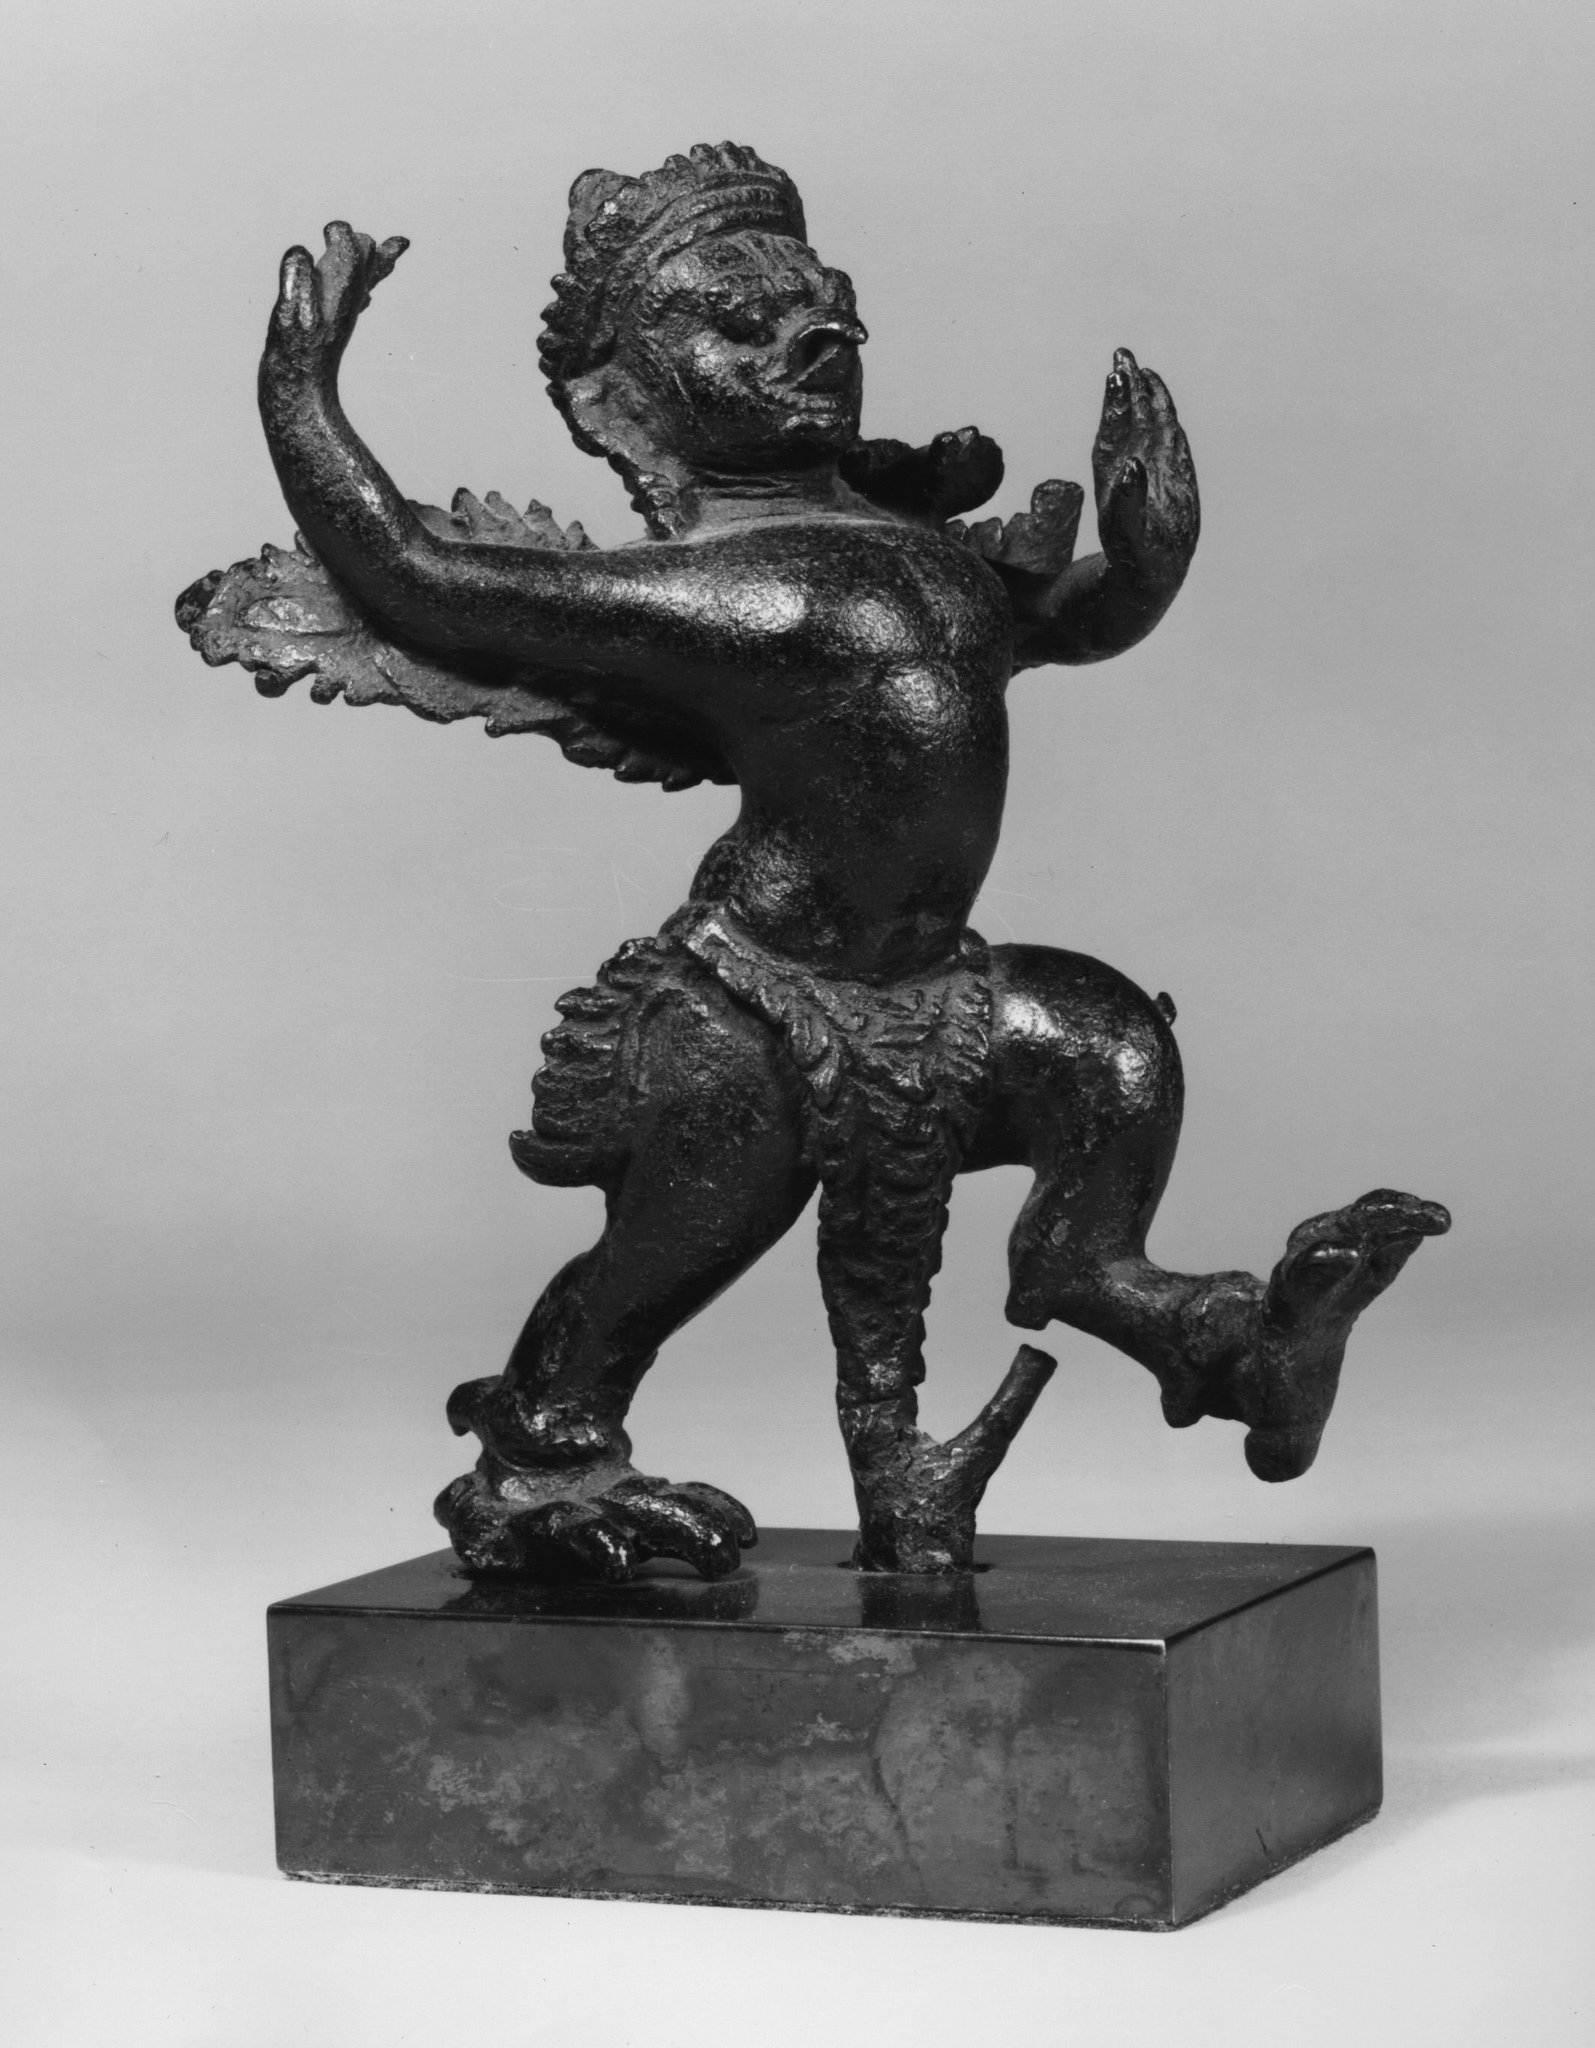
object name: figure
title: Striding Garuda (The Royal Solar Bird)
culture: thai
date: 951-975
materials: bronze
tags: mythical creatures